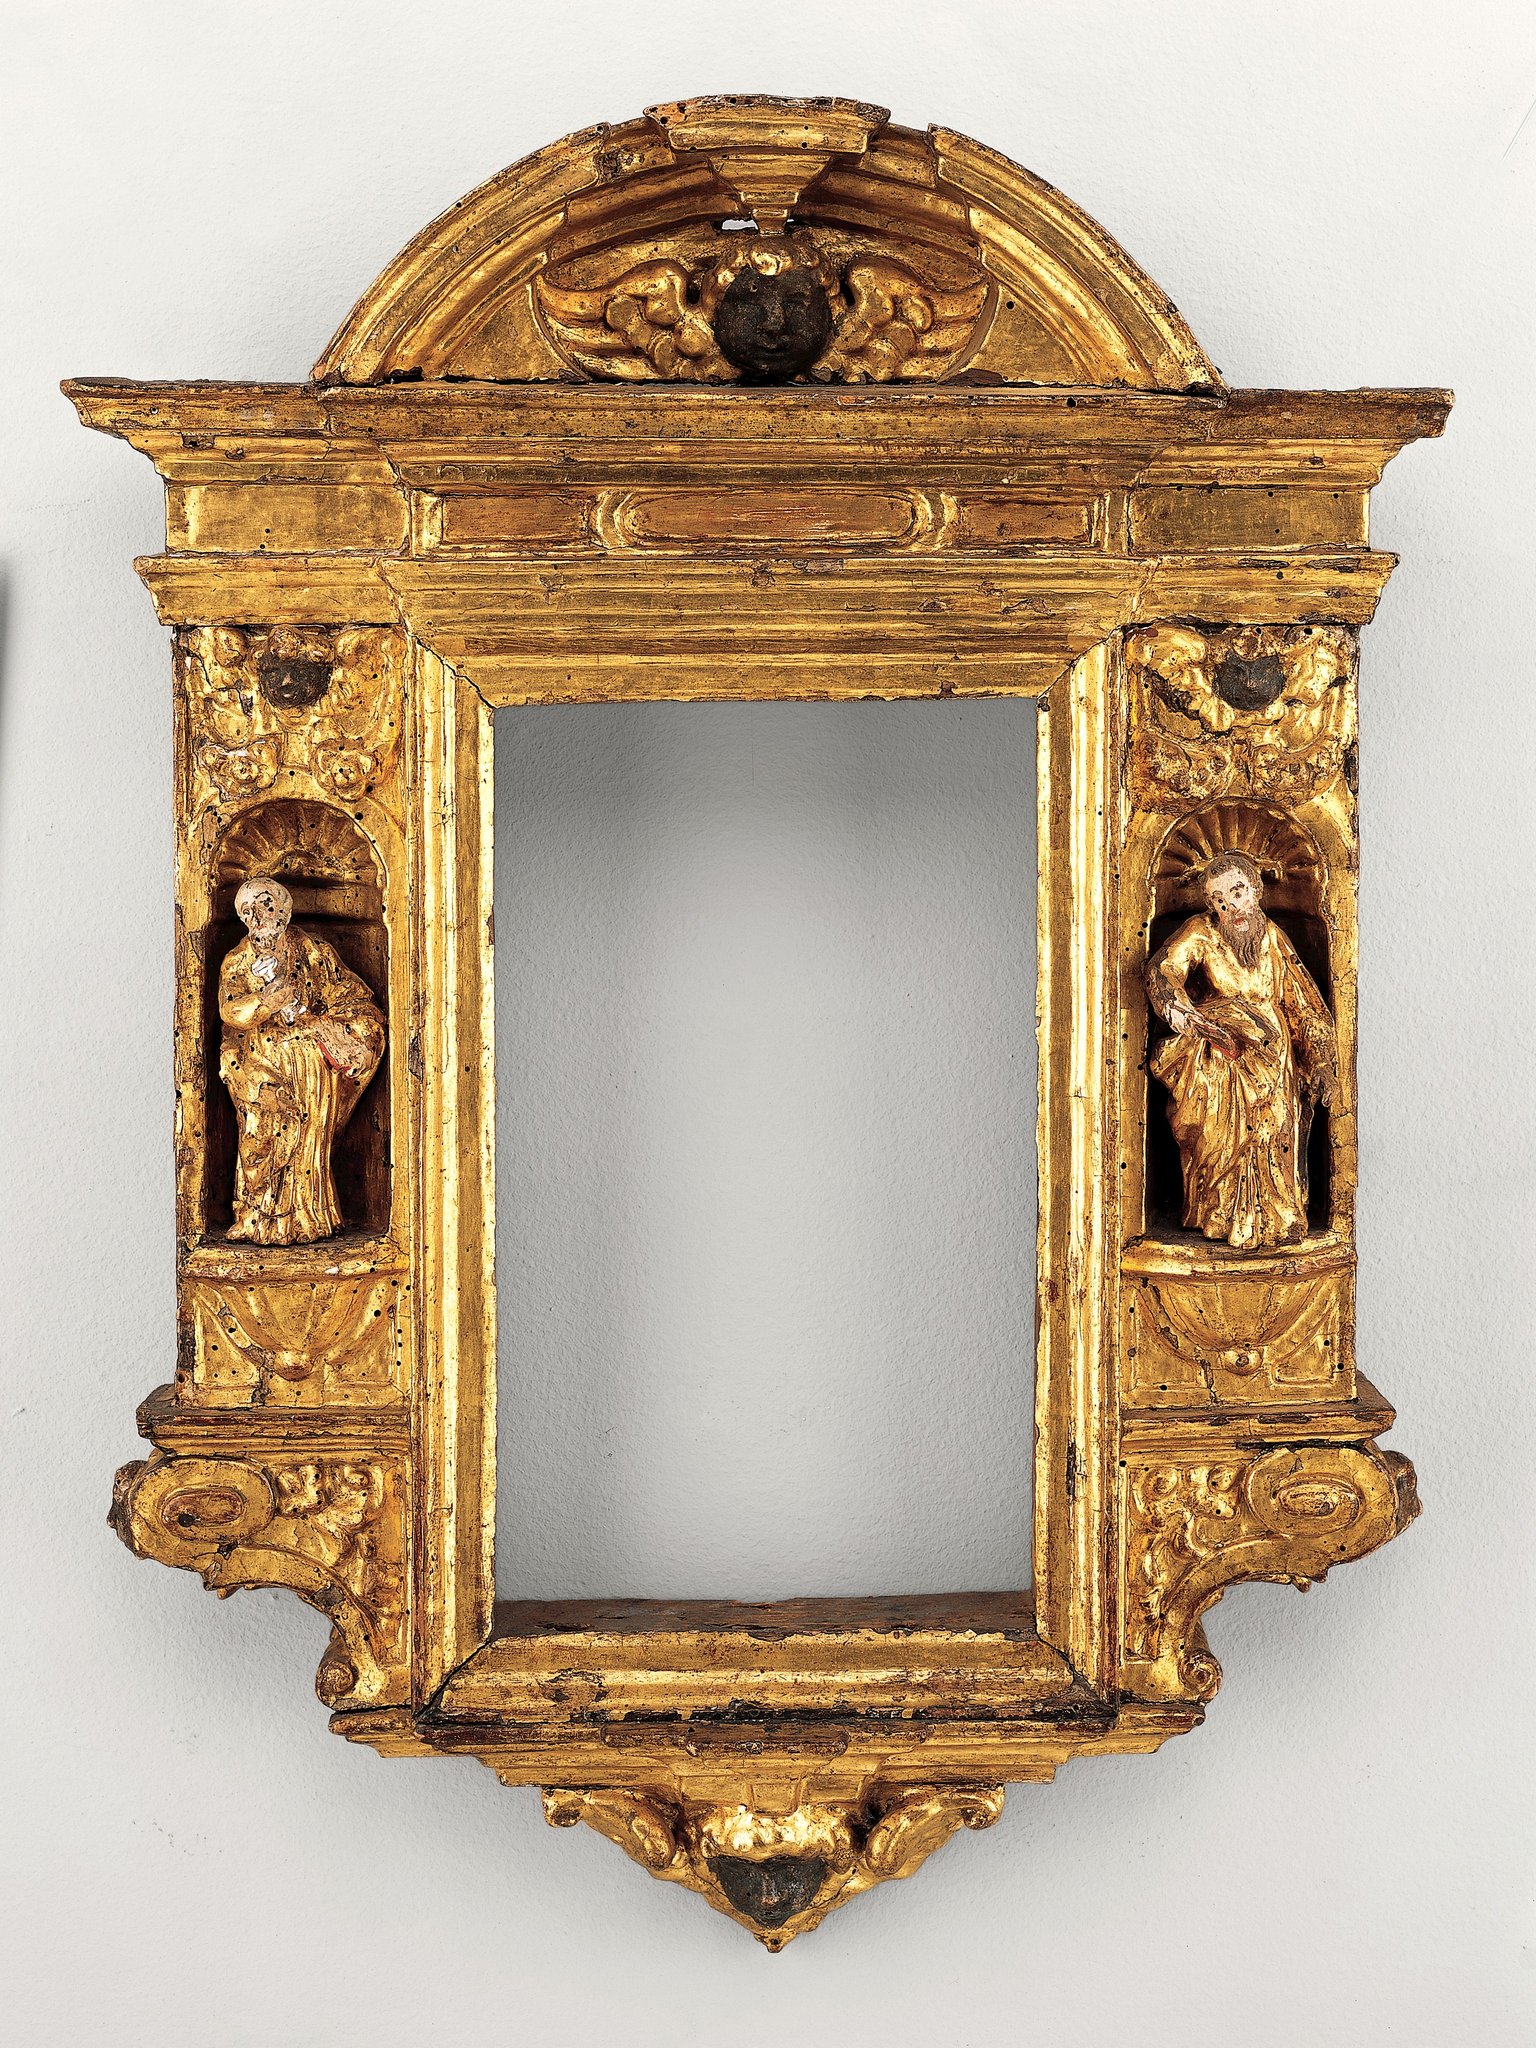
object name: frame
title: Tabernacle frame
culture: italian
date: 1540-1550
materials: wood